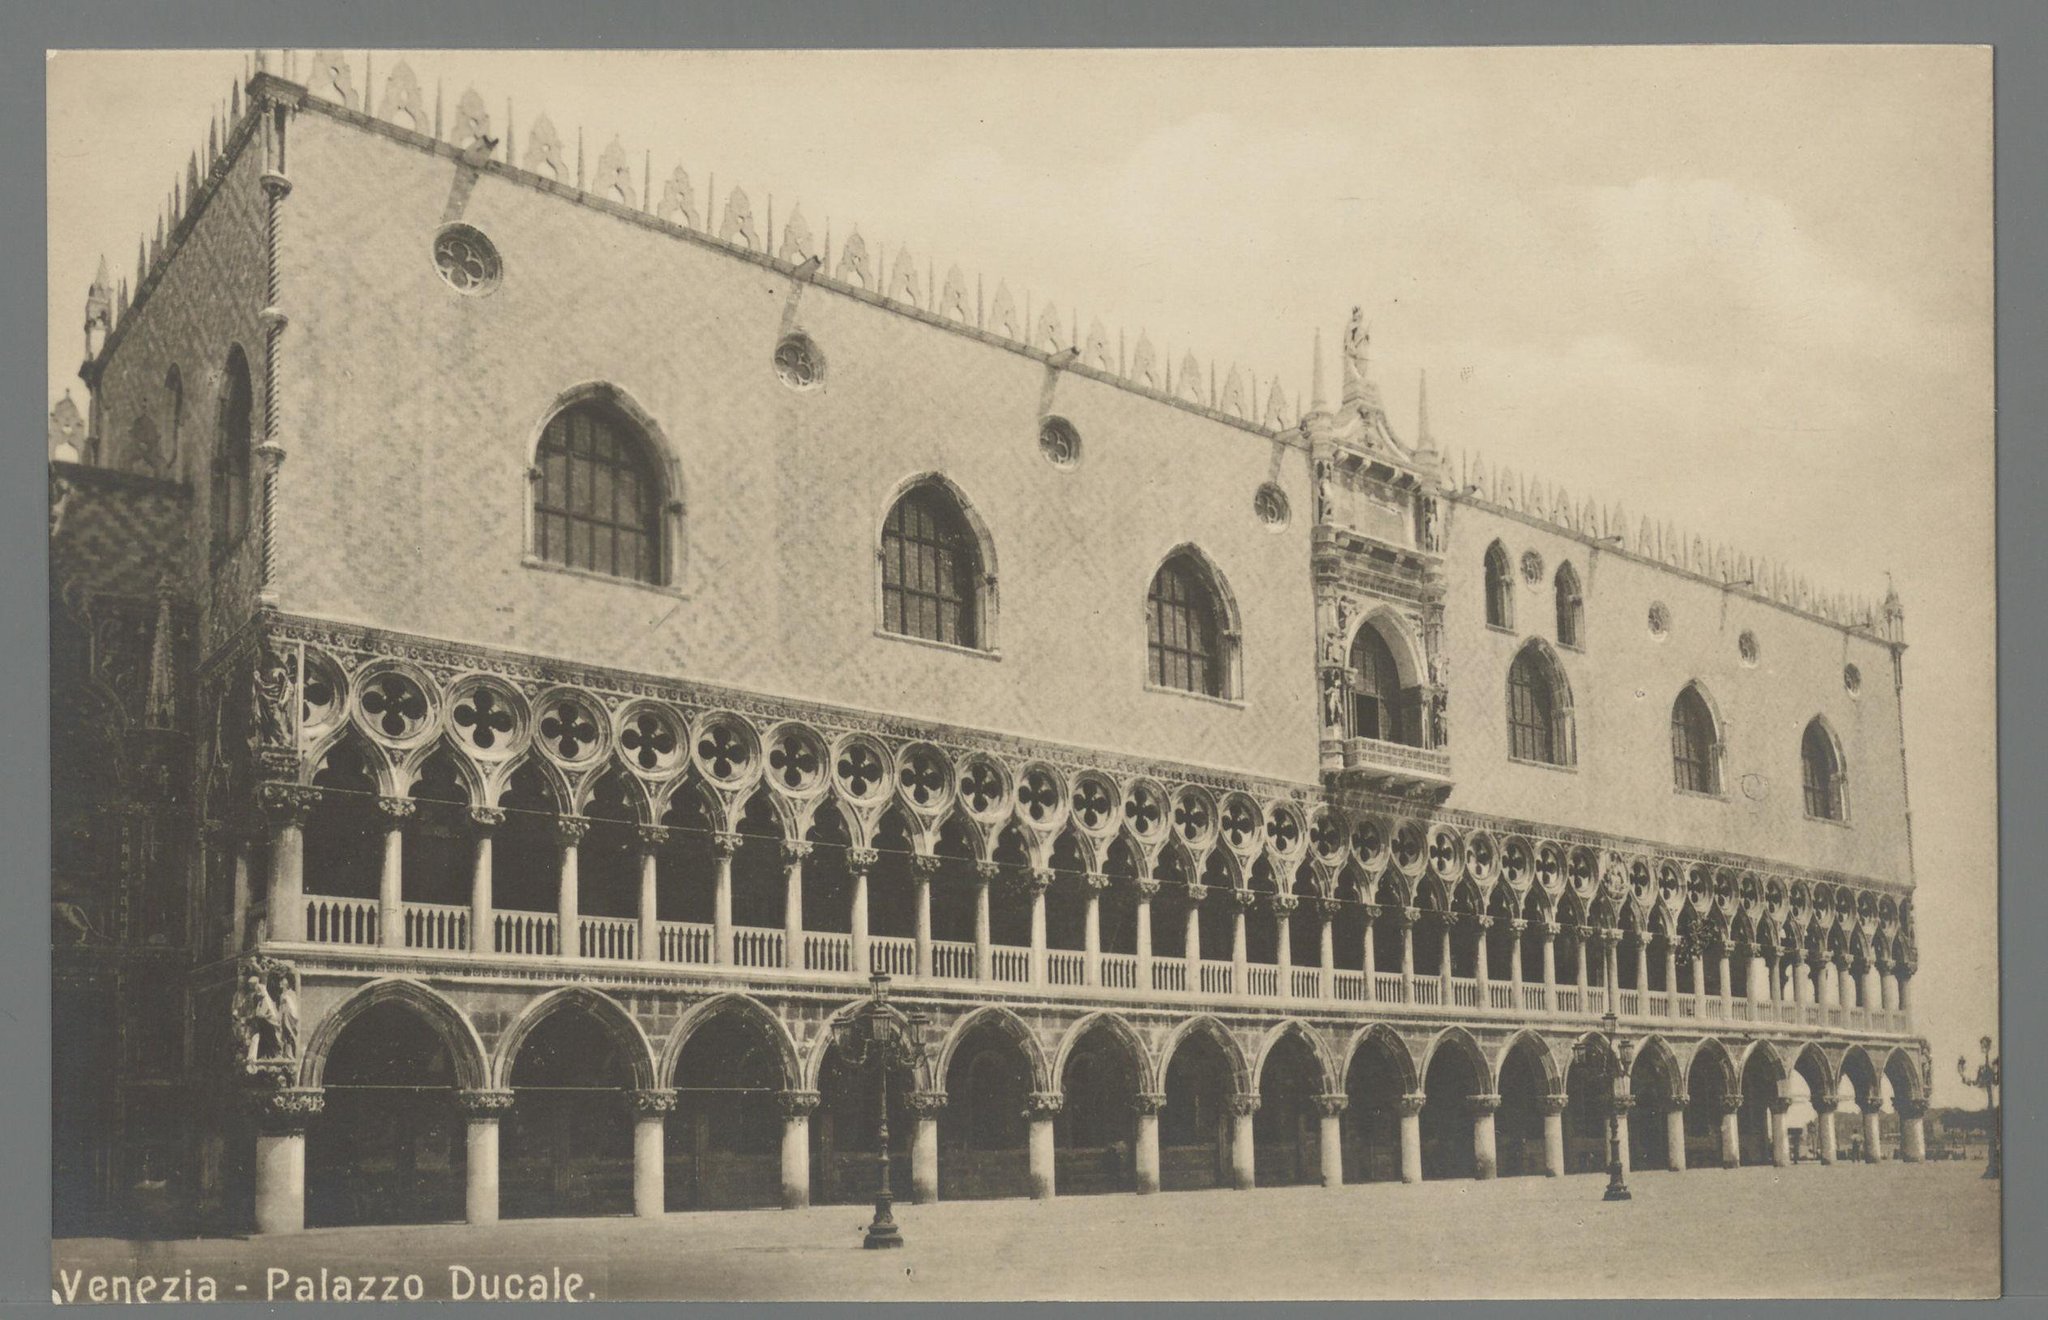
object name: ansichtkaart, prentbriefkaart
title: Venezia. Palazzo Ducale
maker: Anonymous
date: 1906-1920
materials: photographic support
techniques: photography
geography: venice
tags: palace, square, place, circus, etc. (+ city(-scape) with figures, staffage)